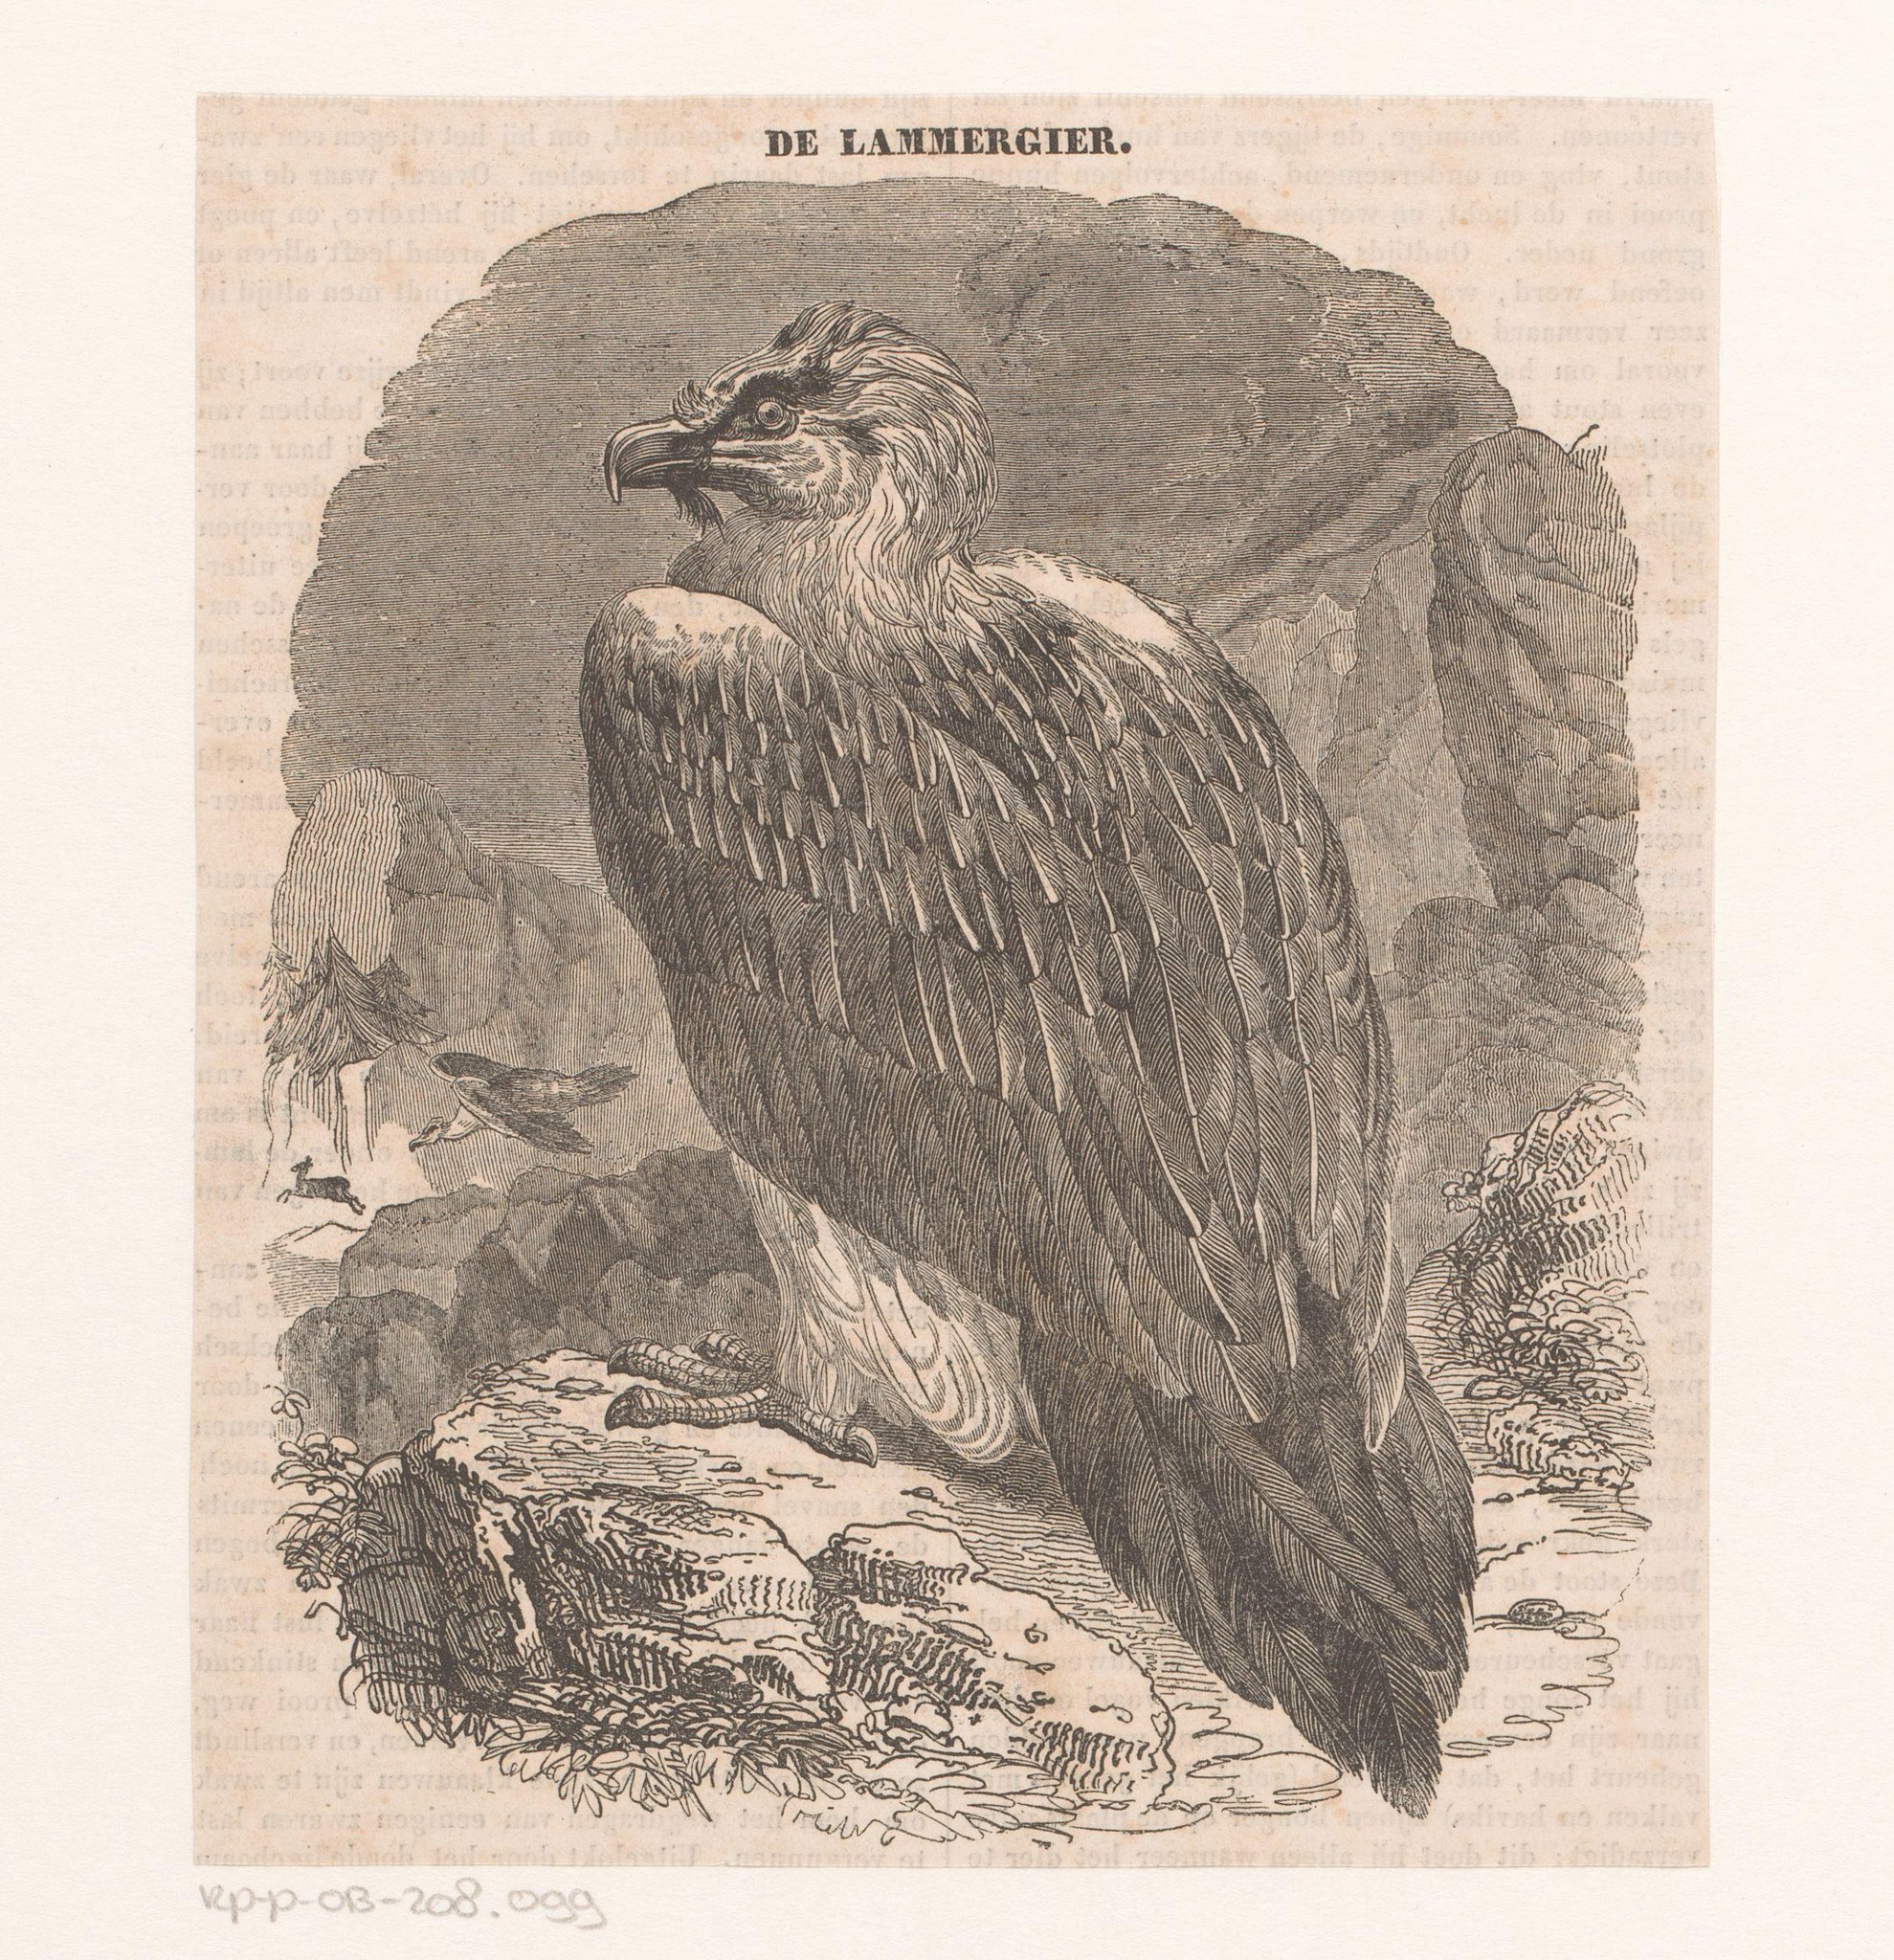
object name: print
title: Lammergier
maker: Anonymous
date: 1800-1899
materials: paper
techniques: letterpress printing, engraving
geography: netherlands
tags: predatory birds: vulture